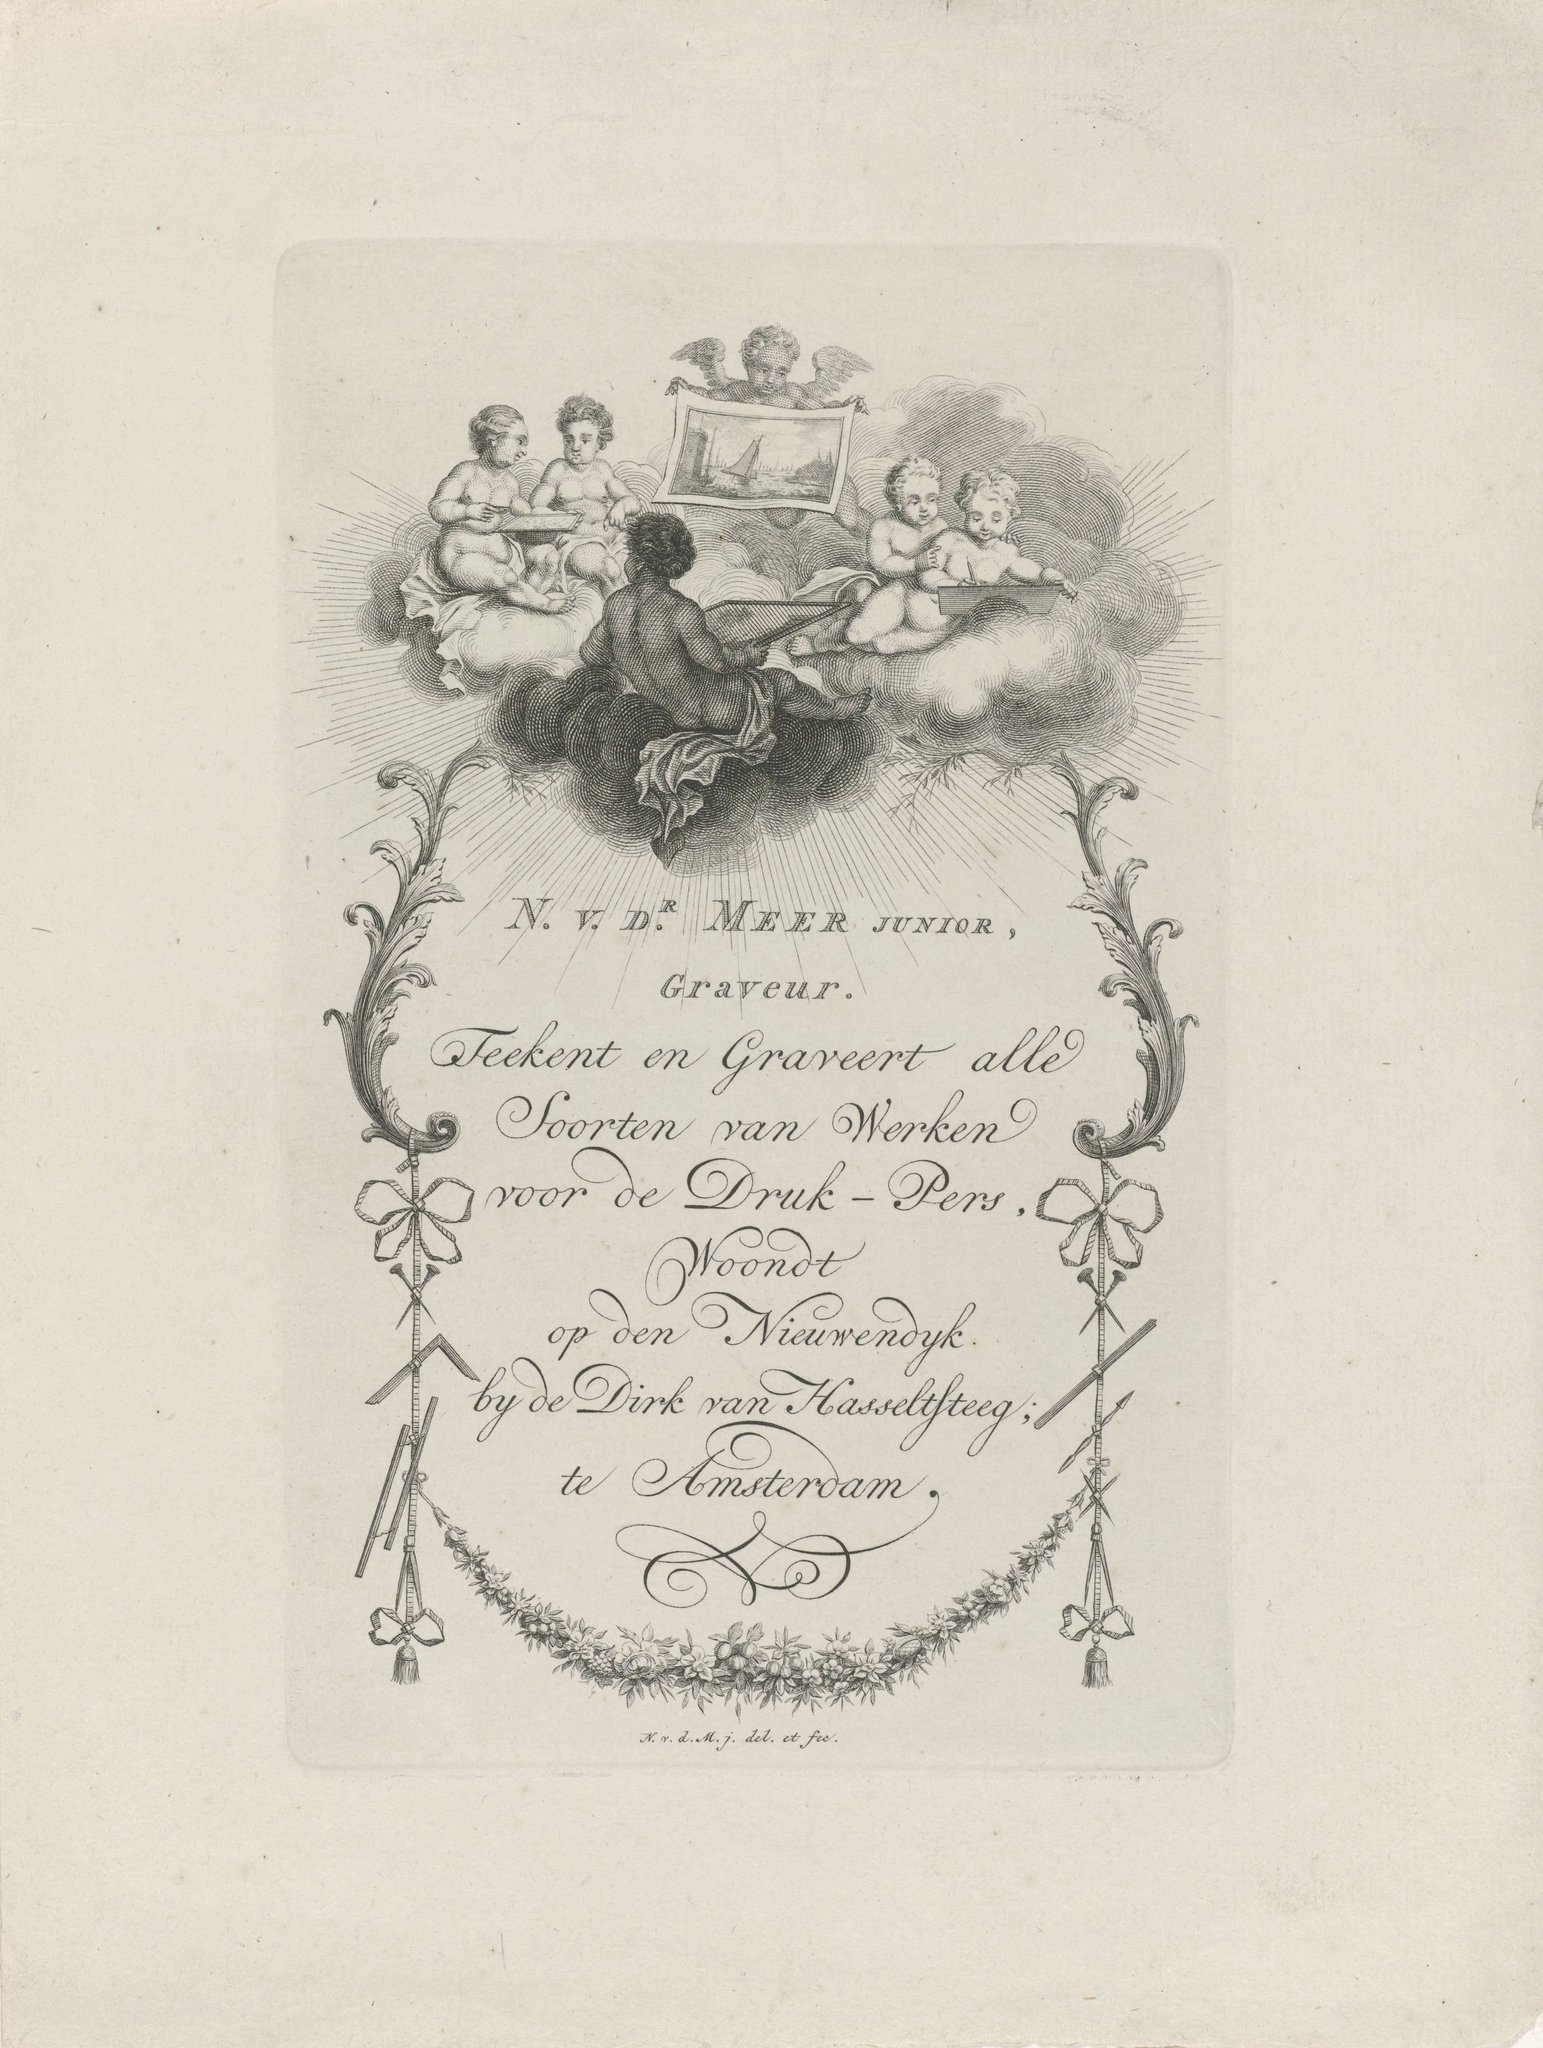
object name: print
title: Reclame voor prentmaker Noach van der Meer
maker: noach van der meer (ii)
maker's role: draughtsman, print maker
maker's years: 1741-1822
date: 1769-1822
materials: paper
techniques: engraving, etching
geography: amsterdam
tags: graphic artist (+ materials ~ arts), advertisement, notice, cupids: 'amores', 'amoretti', 'putti'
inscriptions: collector's mark: Lugt 2228, collector's mark: Lugt 2760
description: Reclametekst voor prentmaker Noach van der Meer in een ornamentele omlijsting. In de ornamentele omlijsting is graveergereedschap verwerkt. Bovenaan putti op de wolken. De middelste putto toont een prent de voorstelling van een schip op het water.